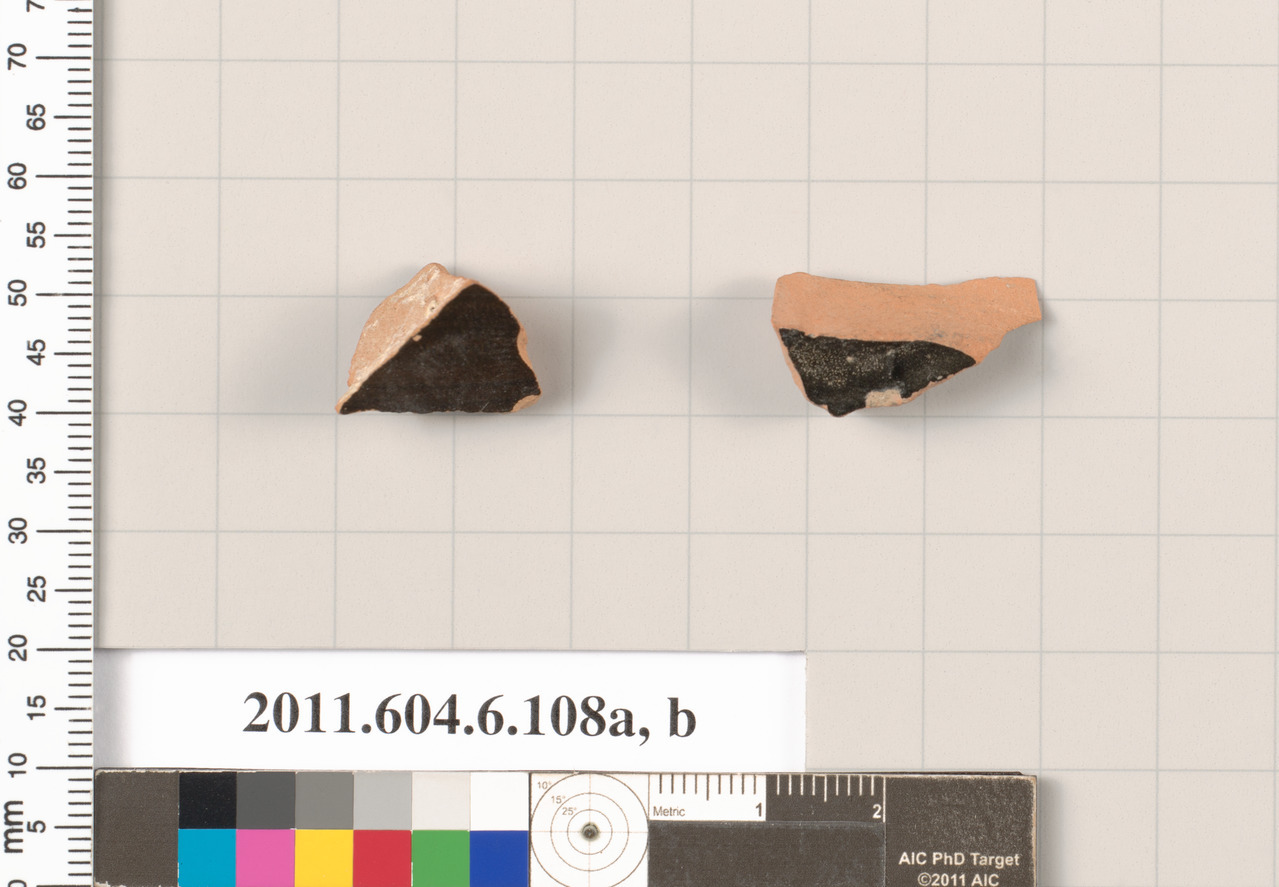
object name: undetermined shape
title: Terracotta fragments of undetermined shapes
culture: greek, attic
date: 600-401 BCE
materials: terracotta